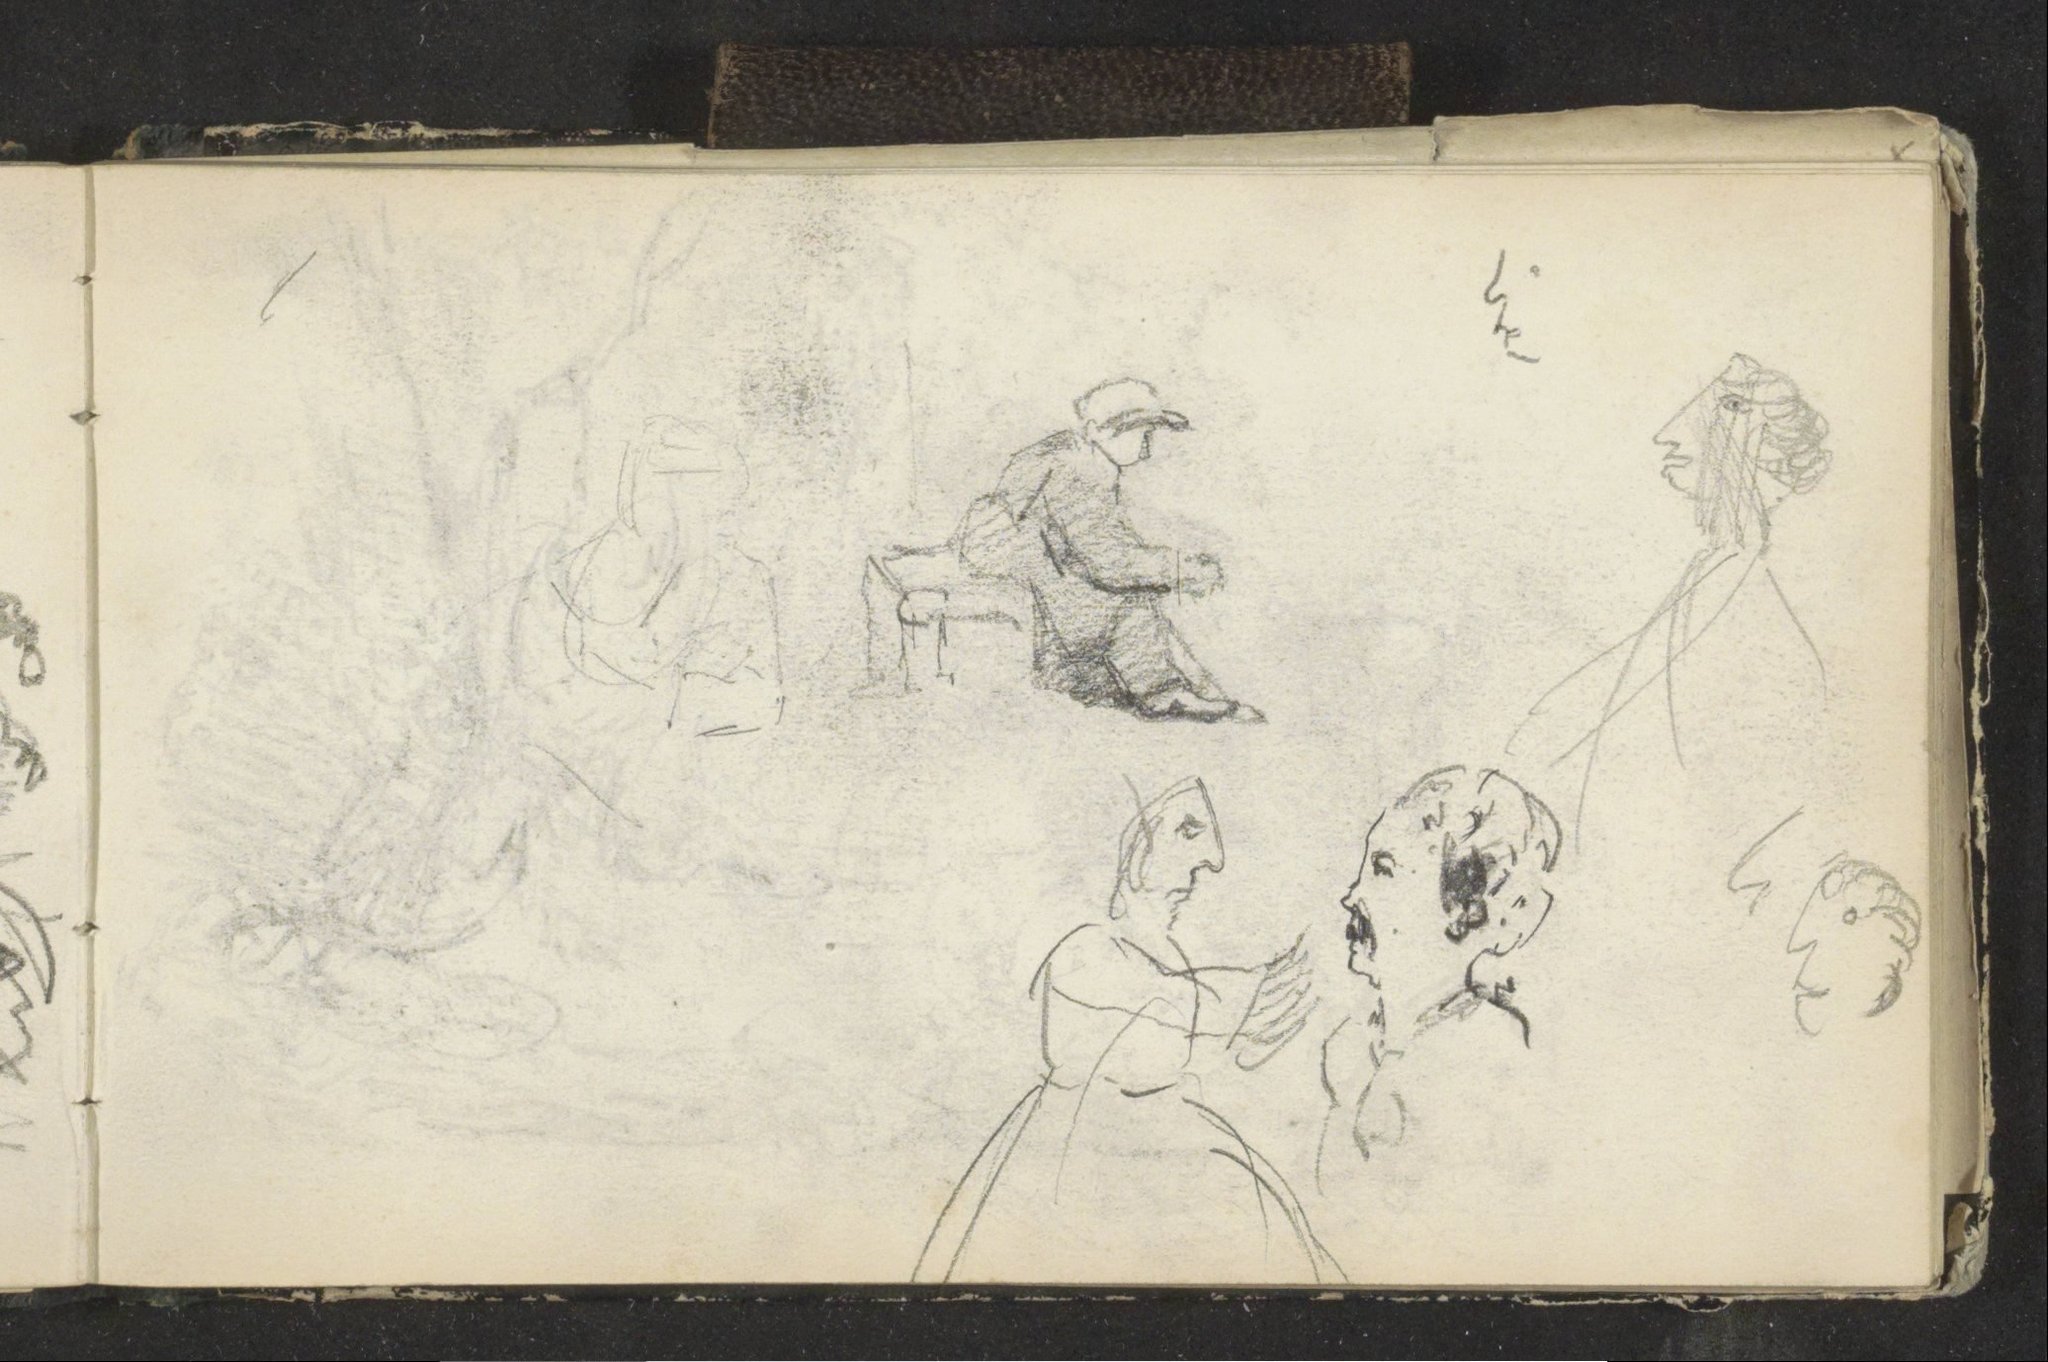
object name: sketchbook leaf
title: Studieblad, onder andere met een zittende jongen op een bank en karikaturale koppen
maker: maria vos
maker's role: draughtsman, painter, print maker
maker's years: 1824-1906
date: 1834-1906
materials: paper, pencil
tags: caricatures (human types)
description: Blad 22 recto uit een schetsboek met 46 bladen.